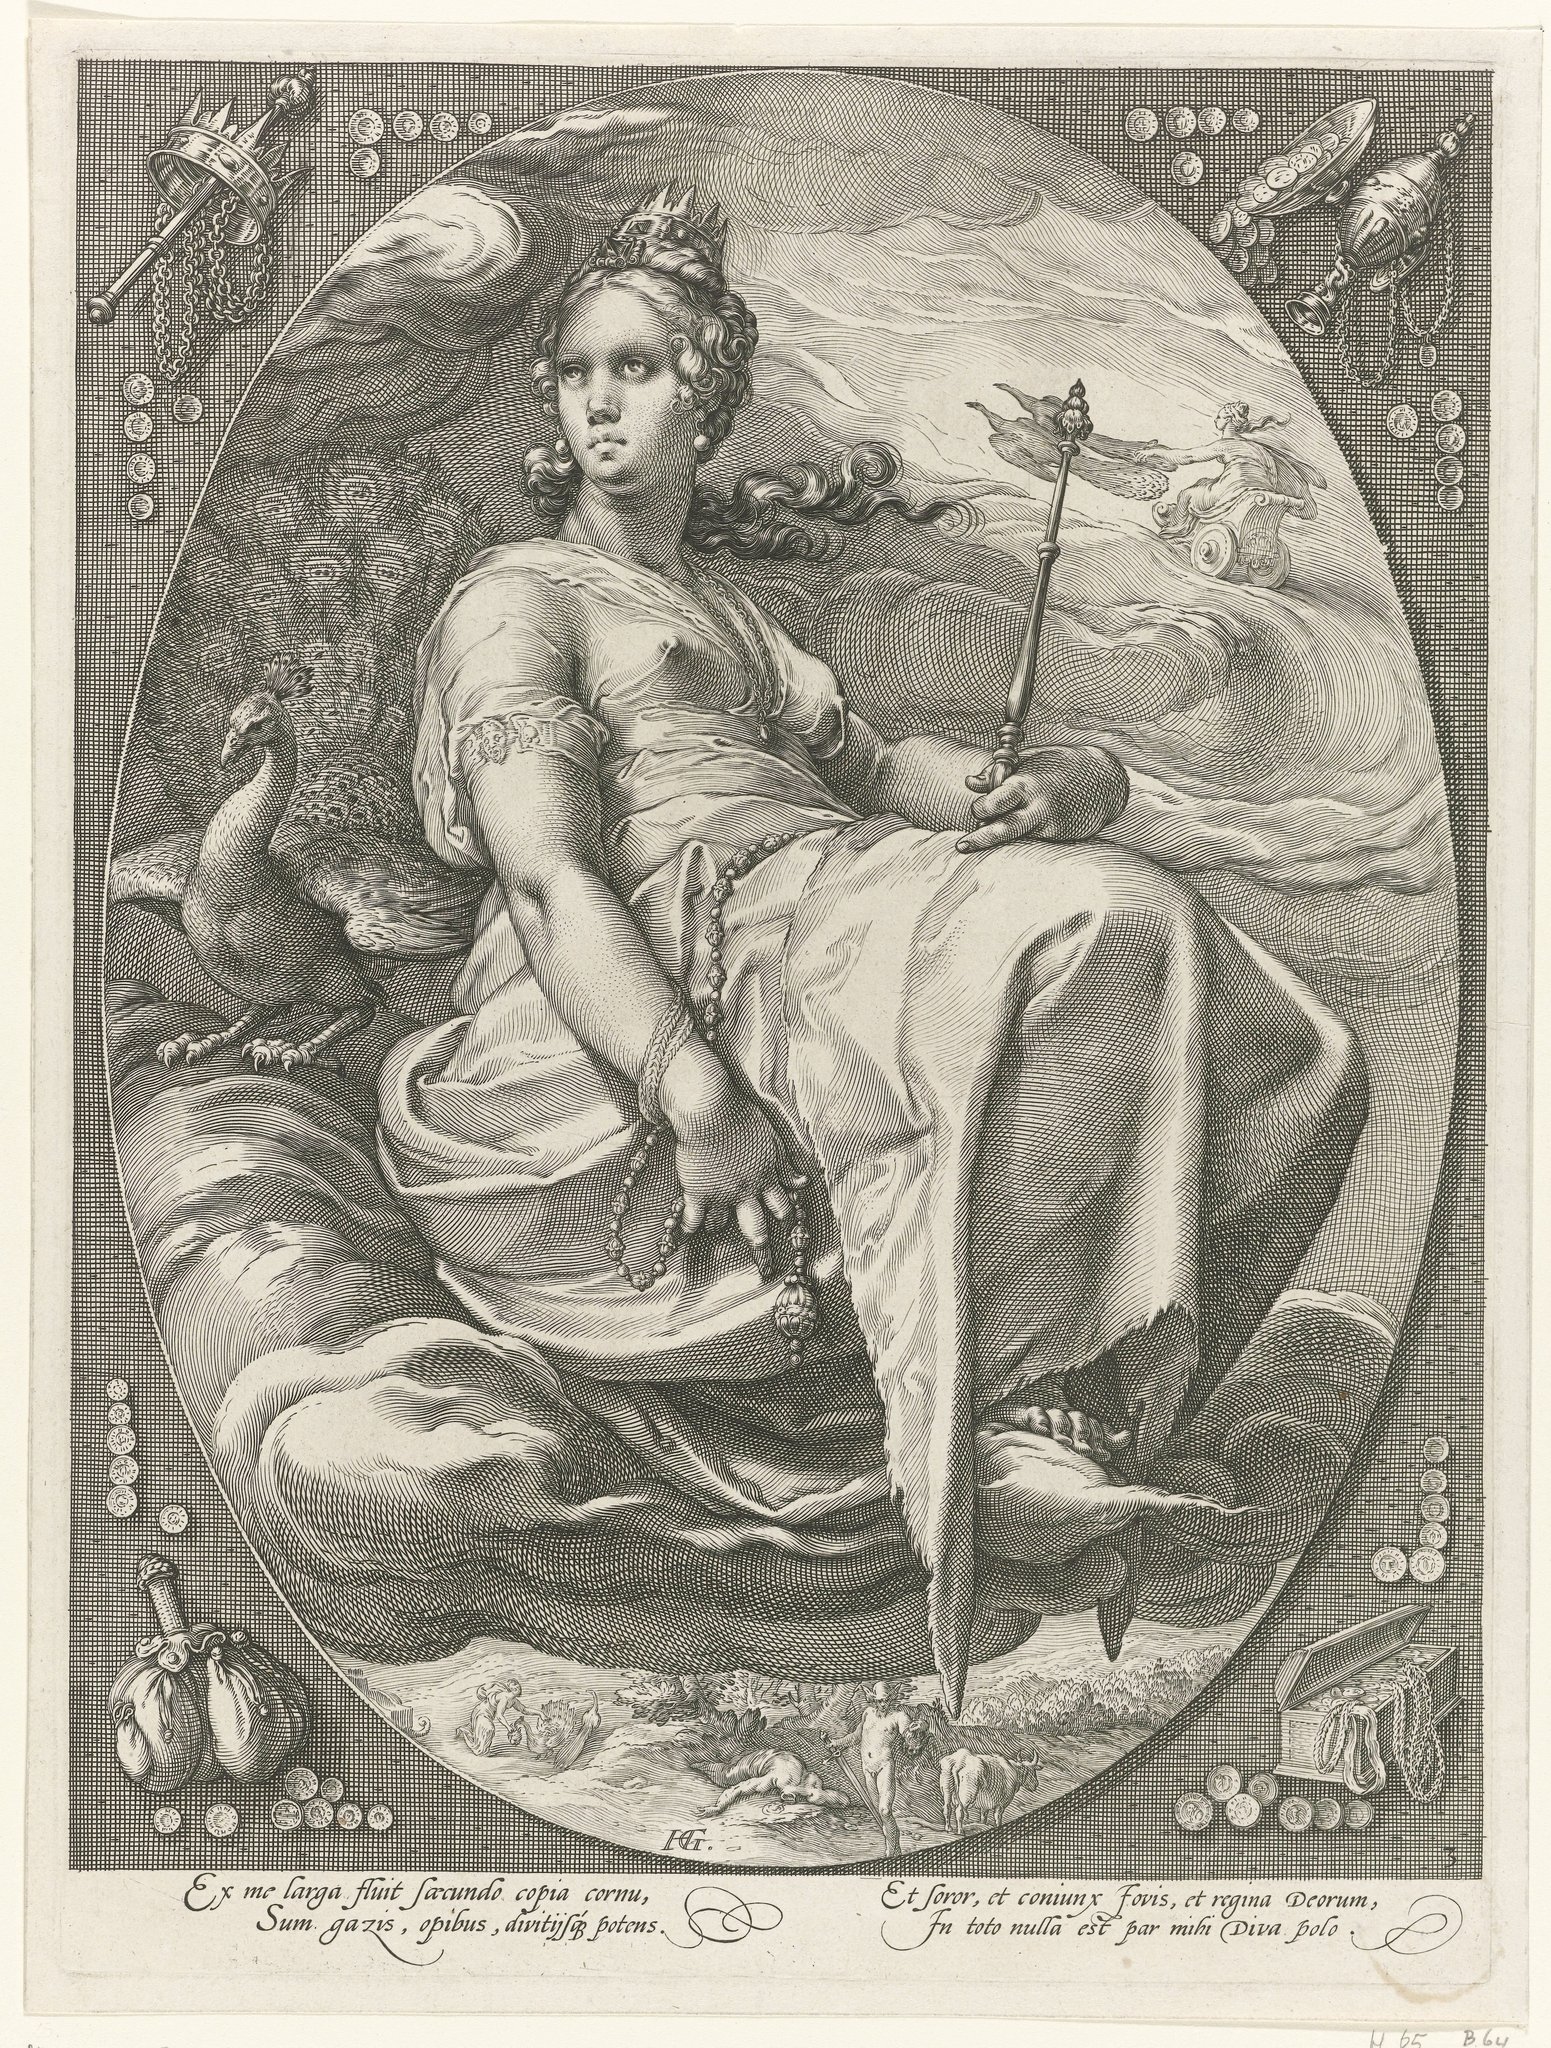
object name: print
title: Juno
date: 1596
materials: paper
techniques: engraving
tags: mercury bringing argus' eyes to juno; juno sets argus' eyes in the tail of her peacock, (story of) juno (hera)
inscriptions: collector's mark: Lugt 240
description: Juno zittend met een pauw op een wolk. Op de achtergrond rijdt Juno in een door pauwen voortgetrokken wagen. Onder de wolk is het verhaal van Juno en de pauw verbeeld.